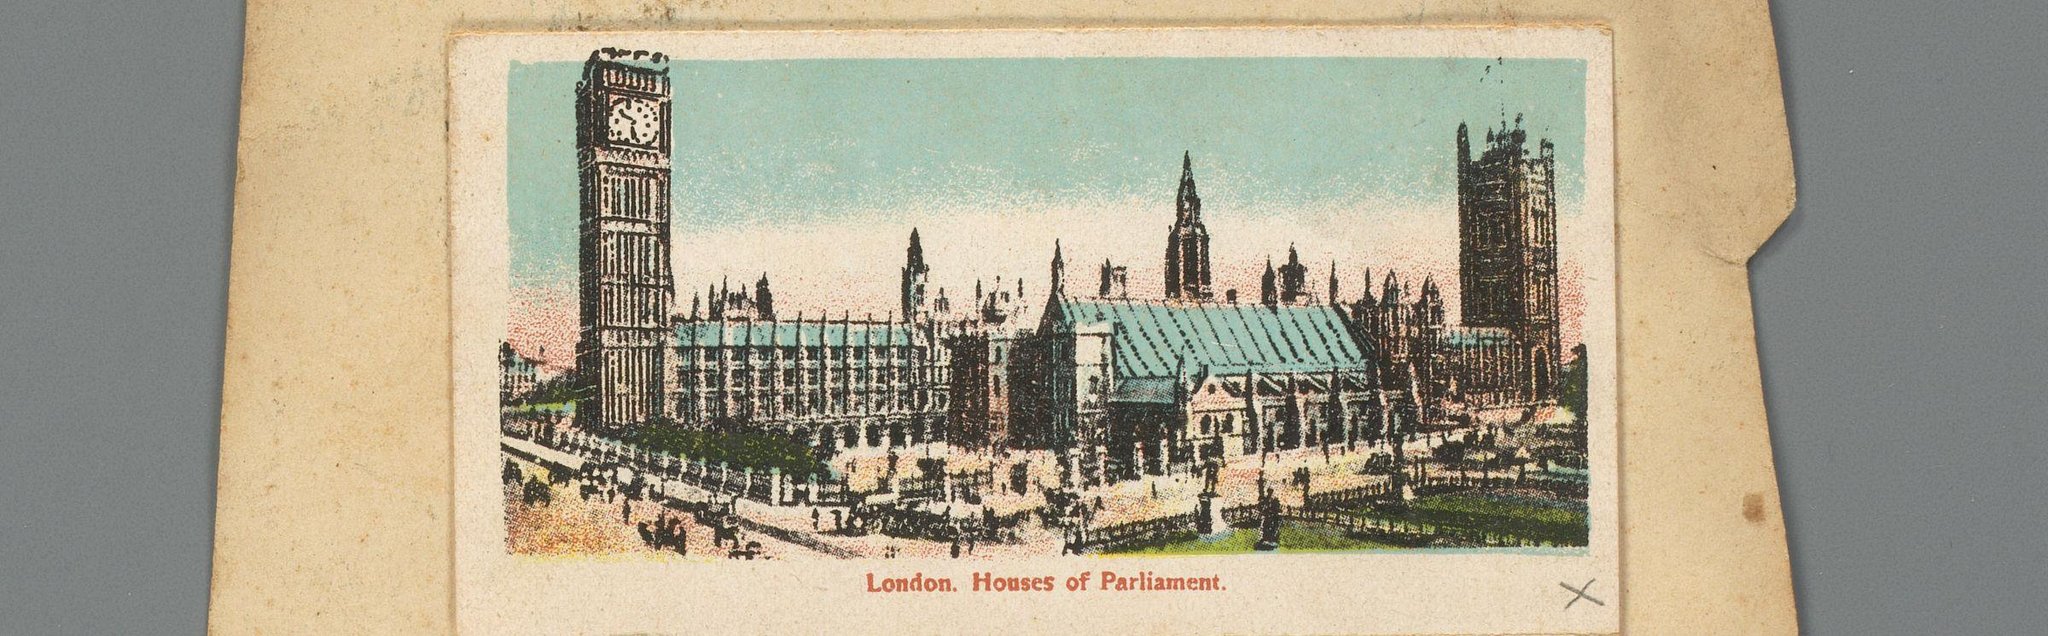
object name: album leaf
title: Gezicht op de Houses of Parliament, Londen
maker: Anonymous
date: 1888-1914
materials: paper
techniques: autotype, chromophotolithography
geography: london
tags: lower house, parliament, chamber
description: Deze prent maakt deel uit van een album.